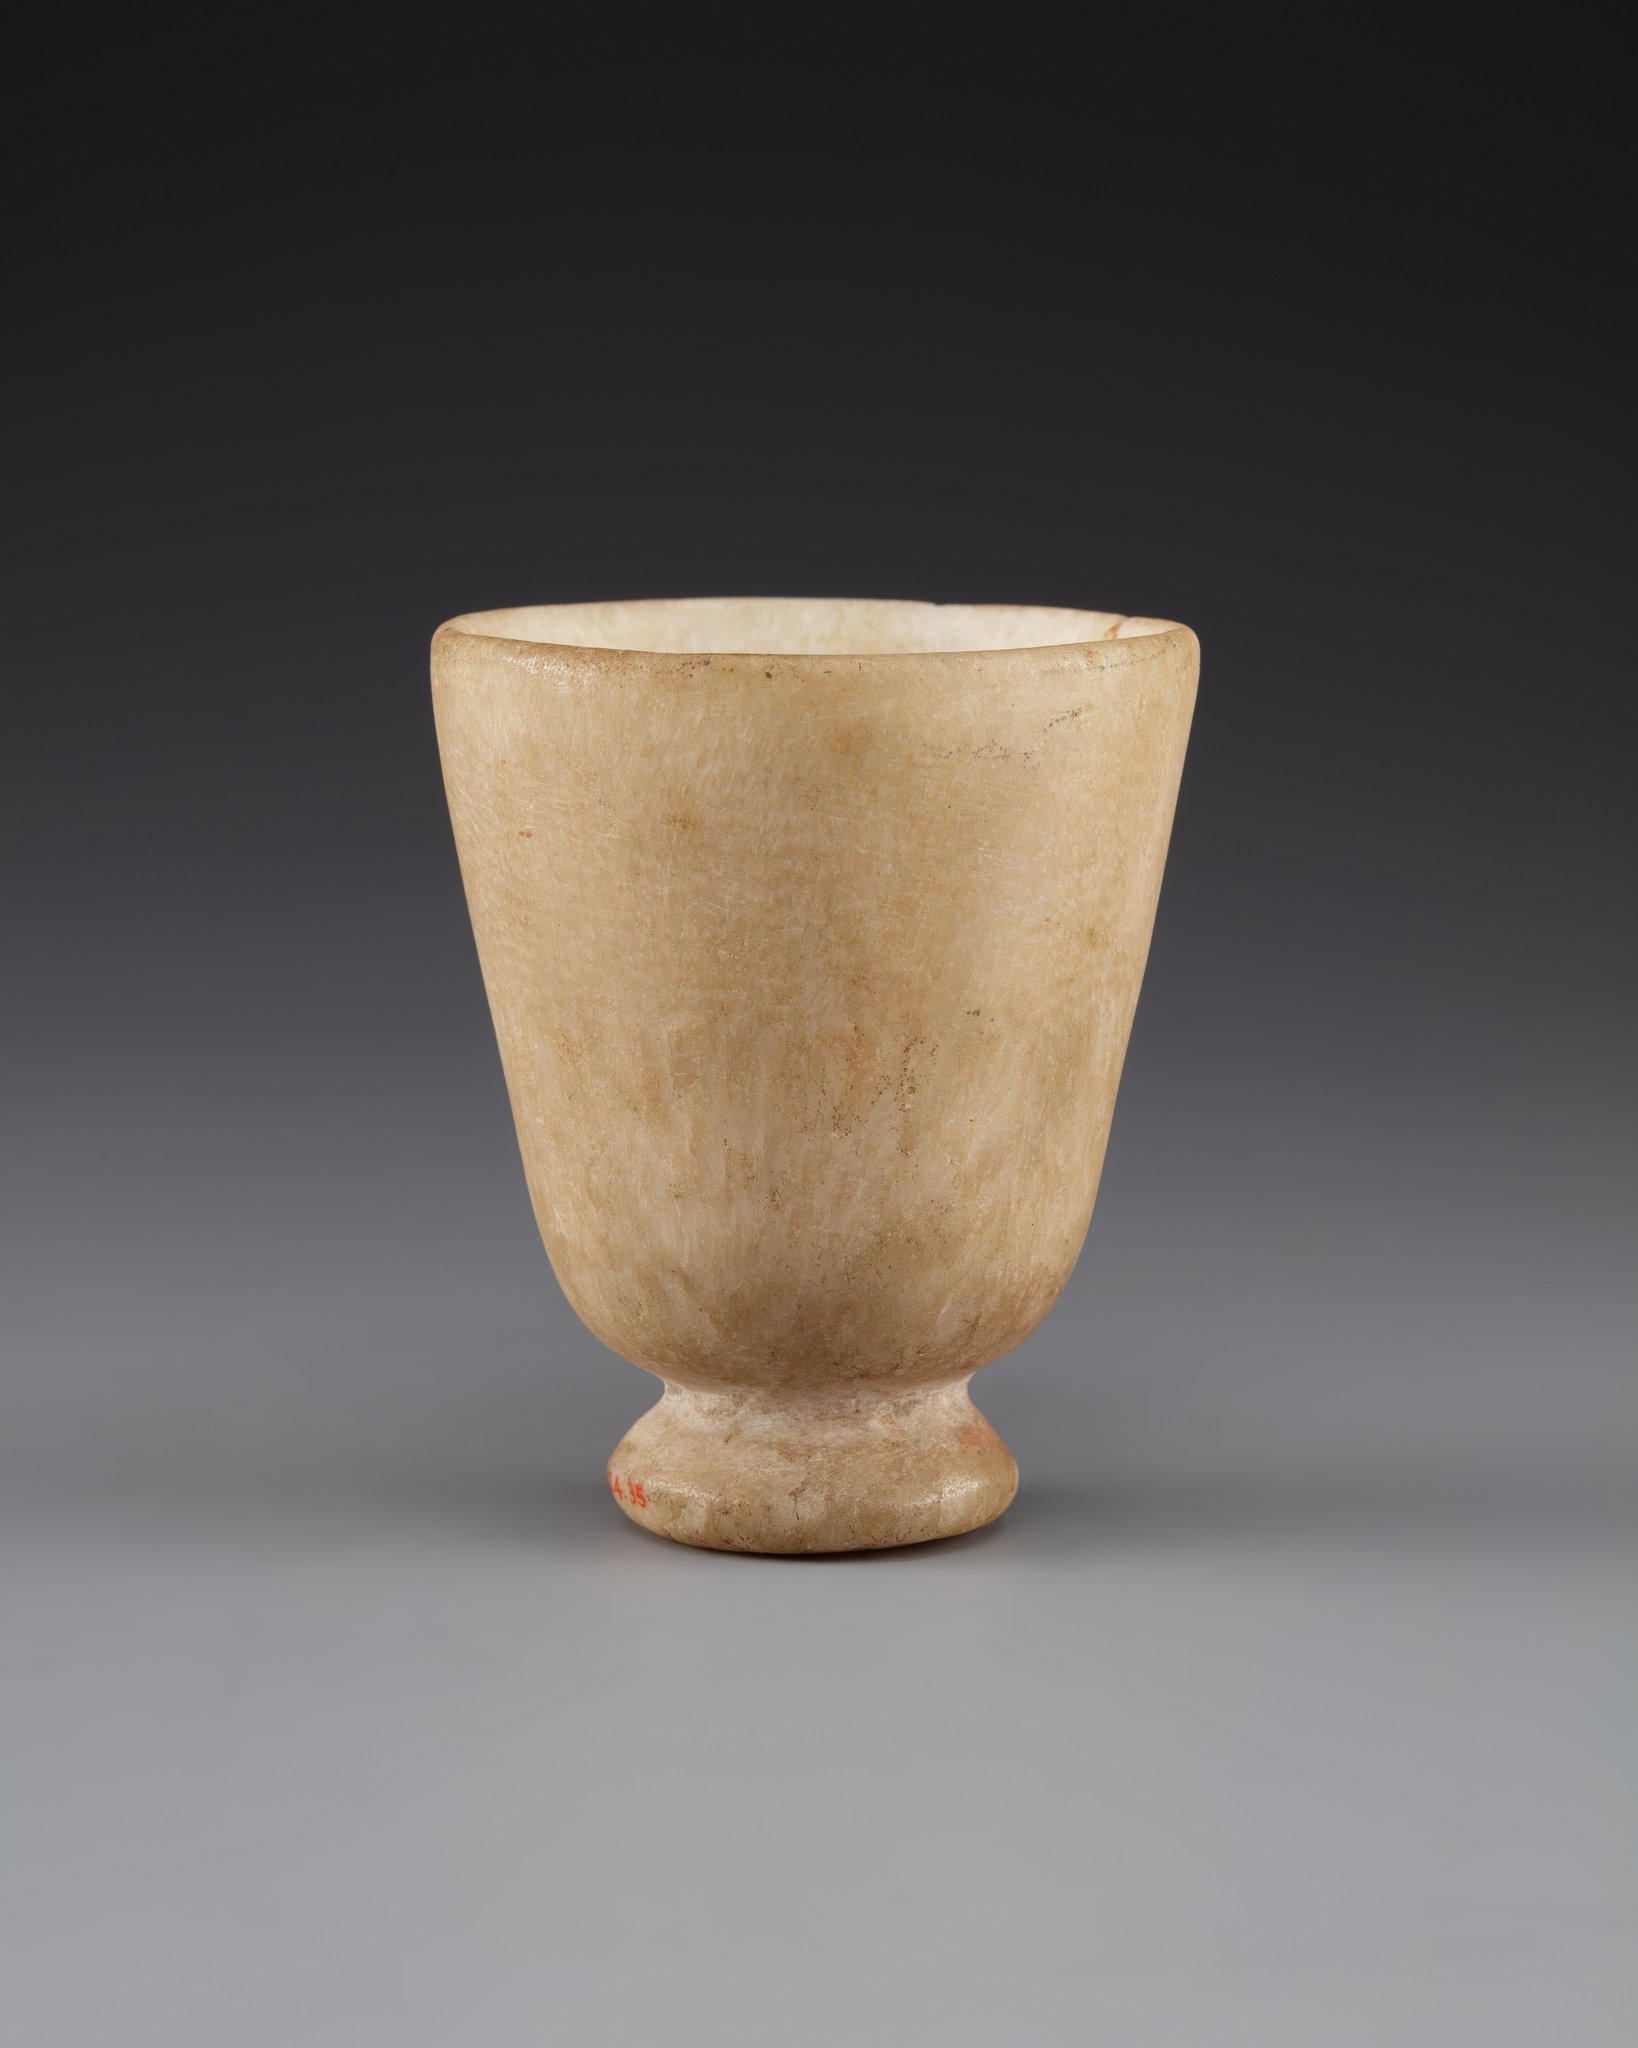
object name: cup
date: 1295-1186 BCE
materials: stone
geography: egypt